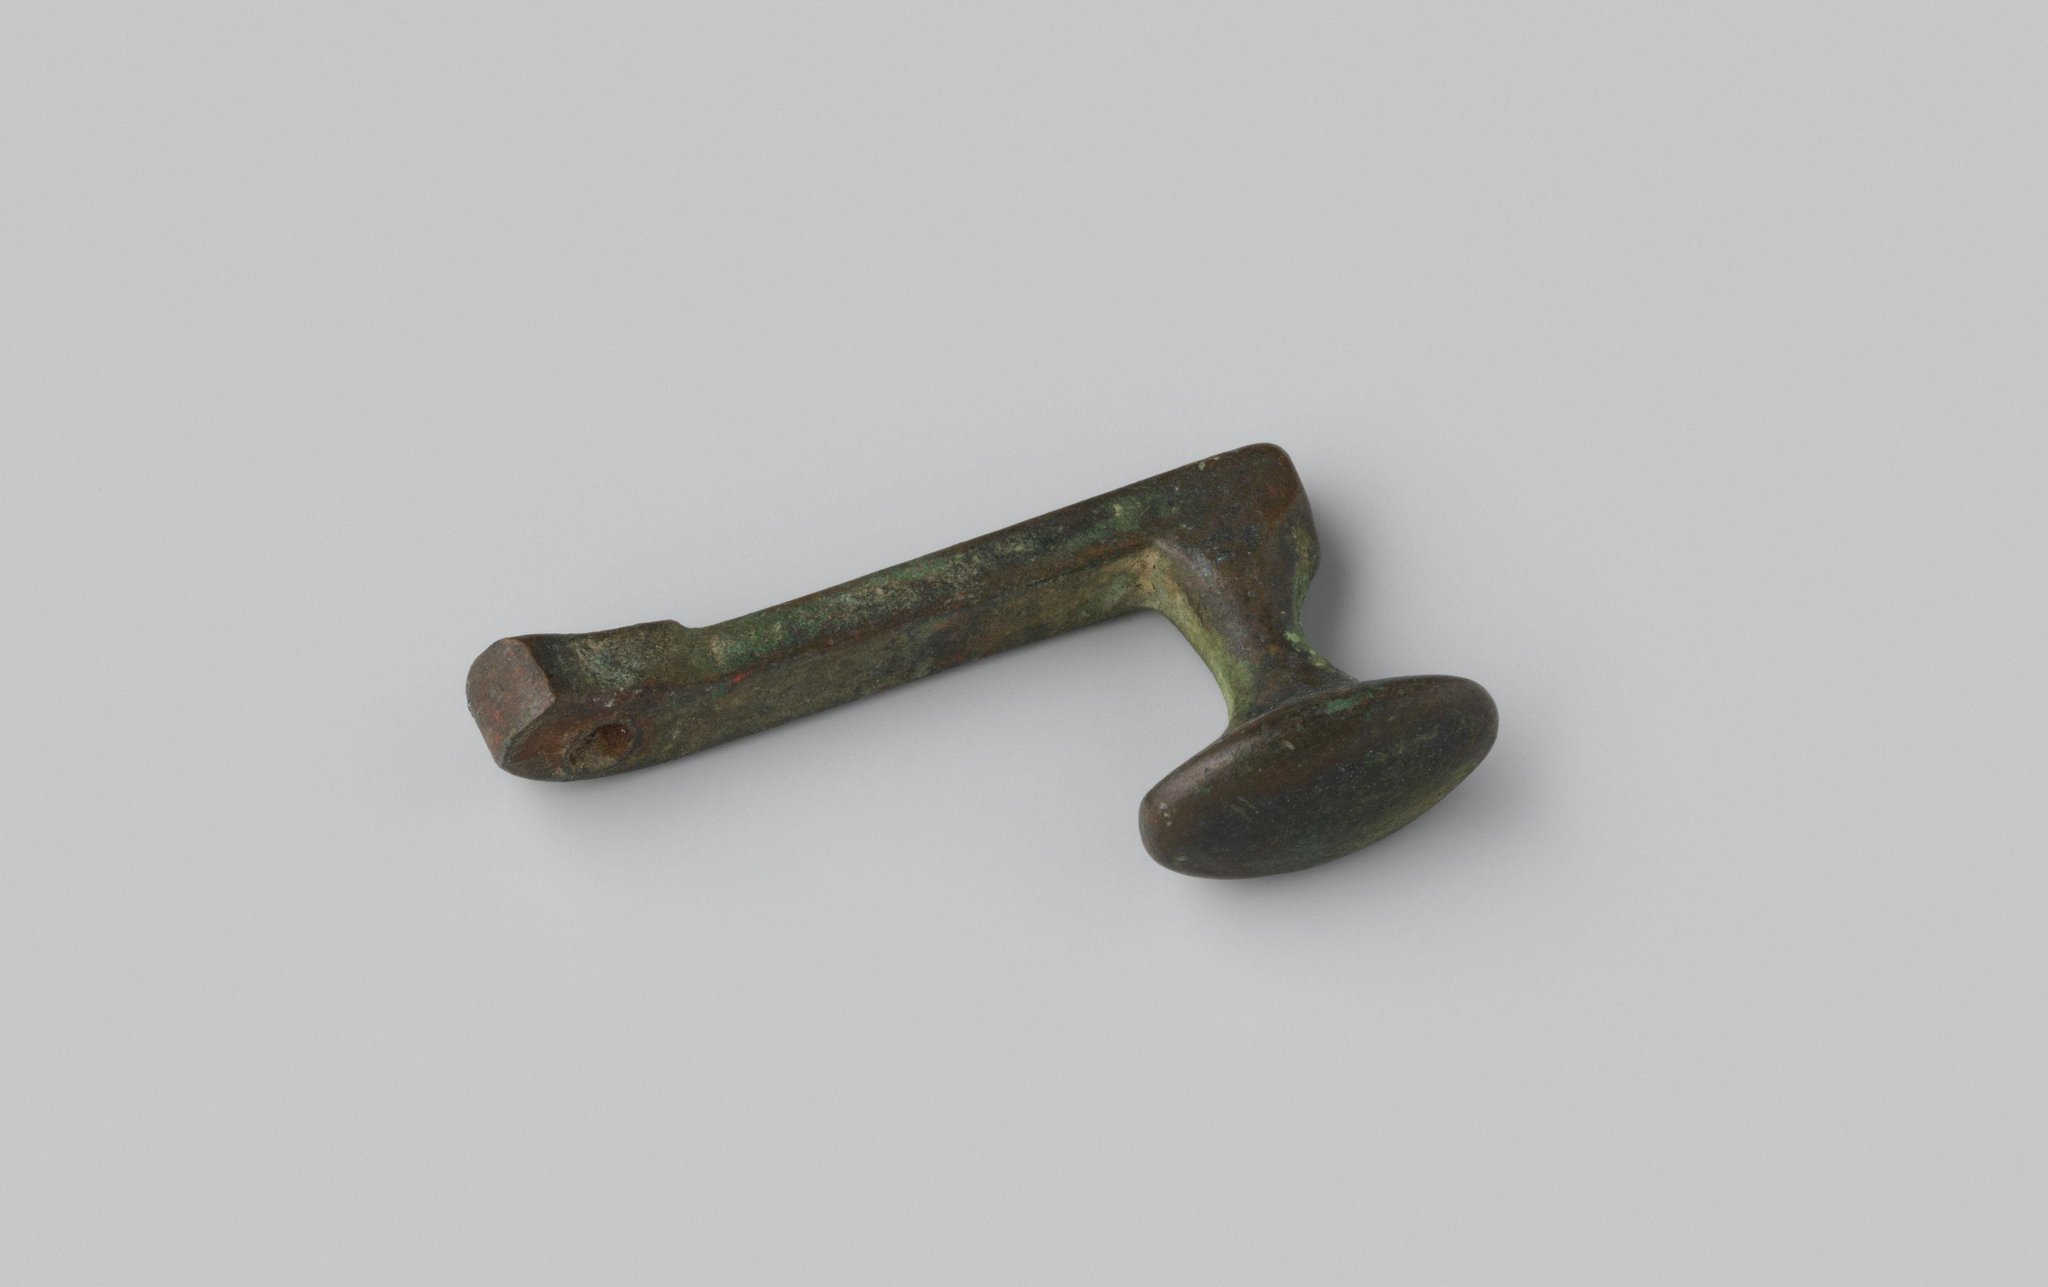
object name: bar handle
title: Klink uit het wrak van de Oost-Indiëvaarder Hollandia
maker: Anonymous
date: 1700-1743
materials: copper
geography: netherlands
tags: verenigde oostindische compagnie, hollandia (schip), annet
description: Locks, fastenings and accessories, latch; rectangular bar slightly sideward curving end, stepped underneath with circular pivot-hole, vertical right-angled knob at other end with oval finial.